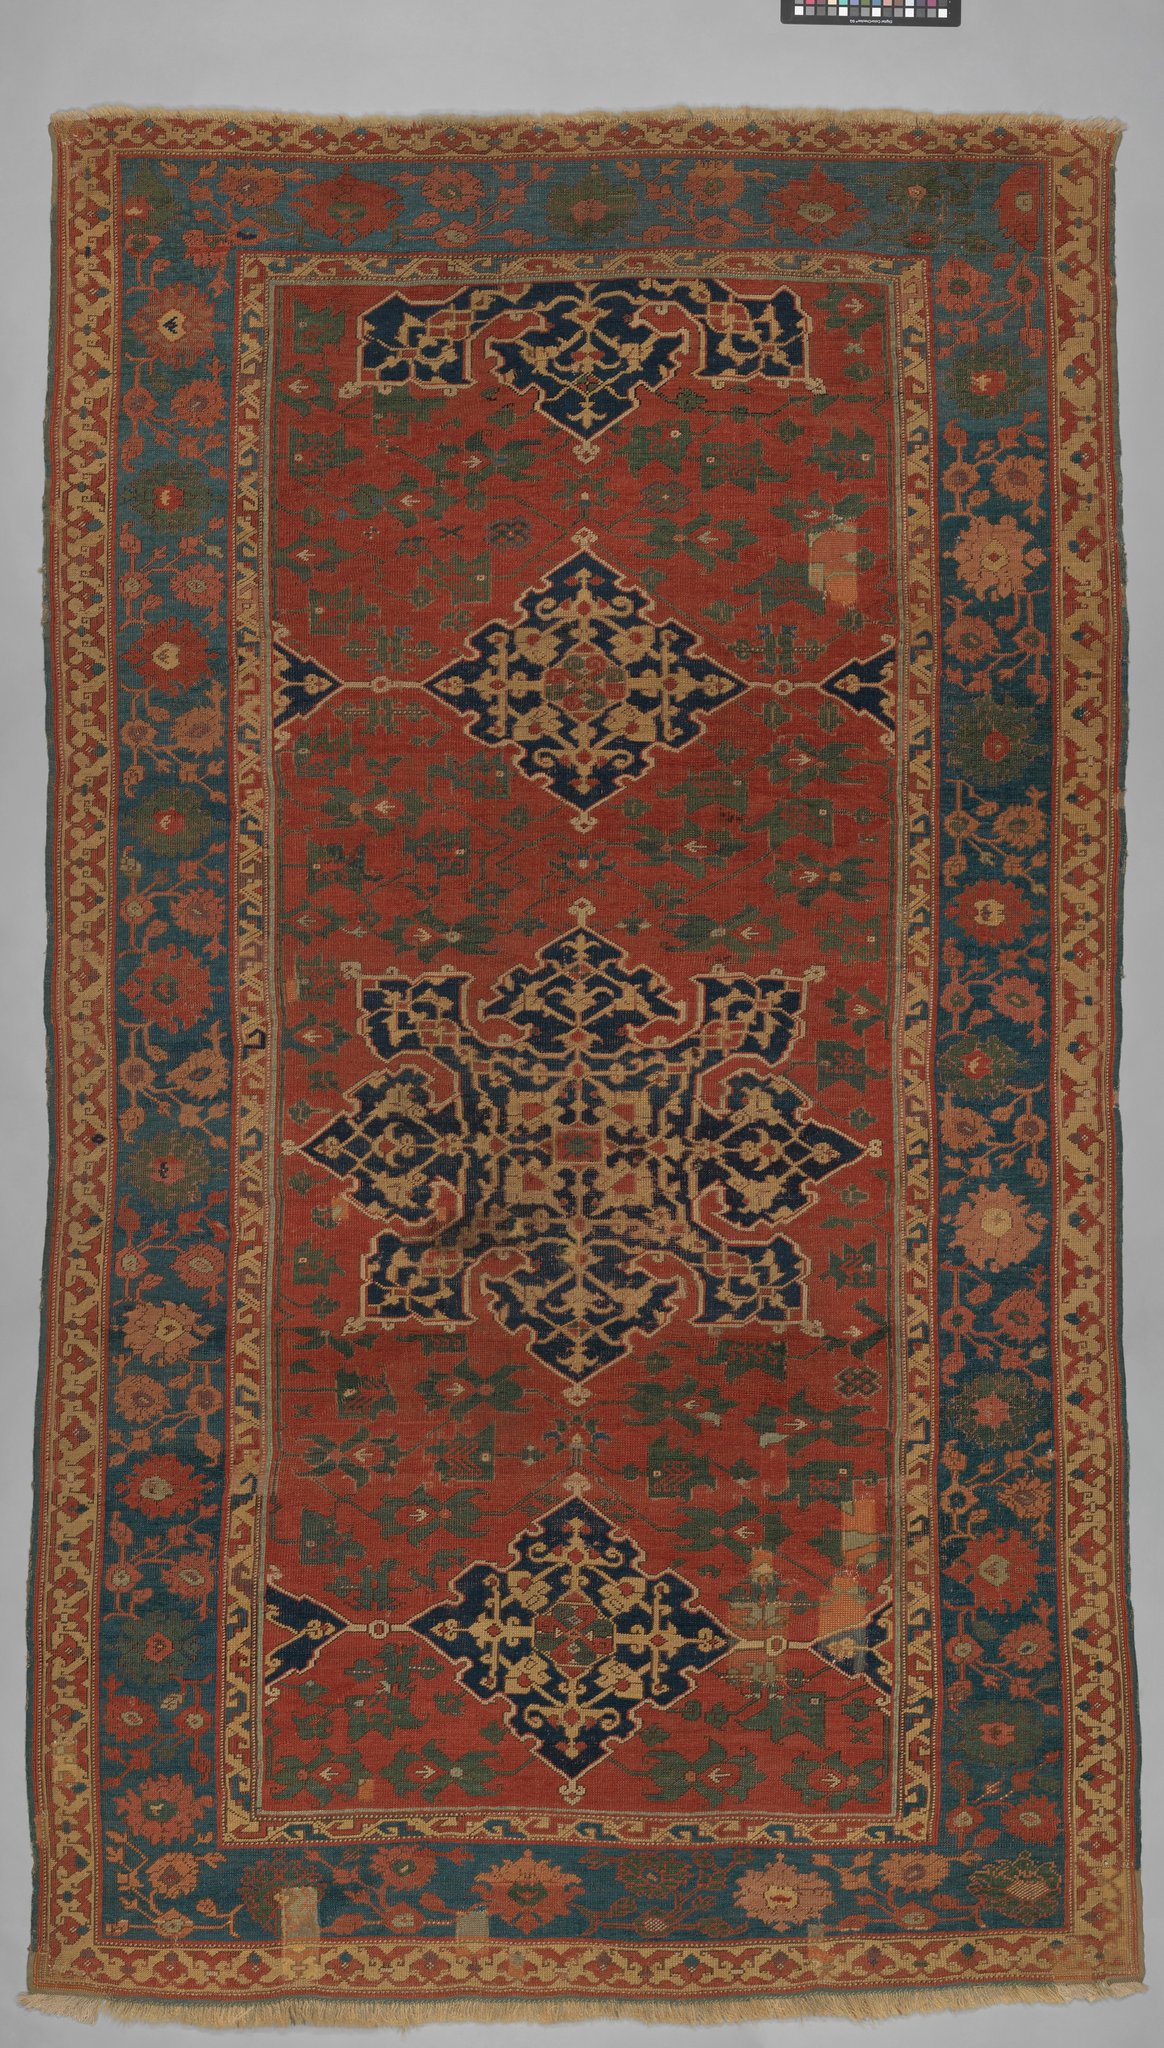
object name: carpet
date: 1801-1900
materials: wool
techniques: pile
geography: turkey